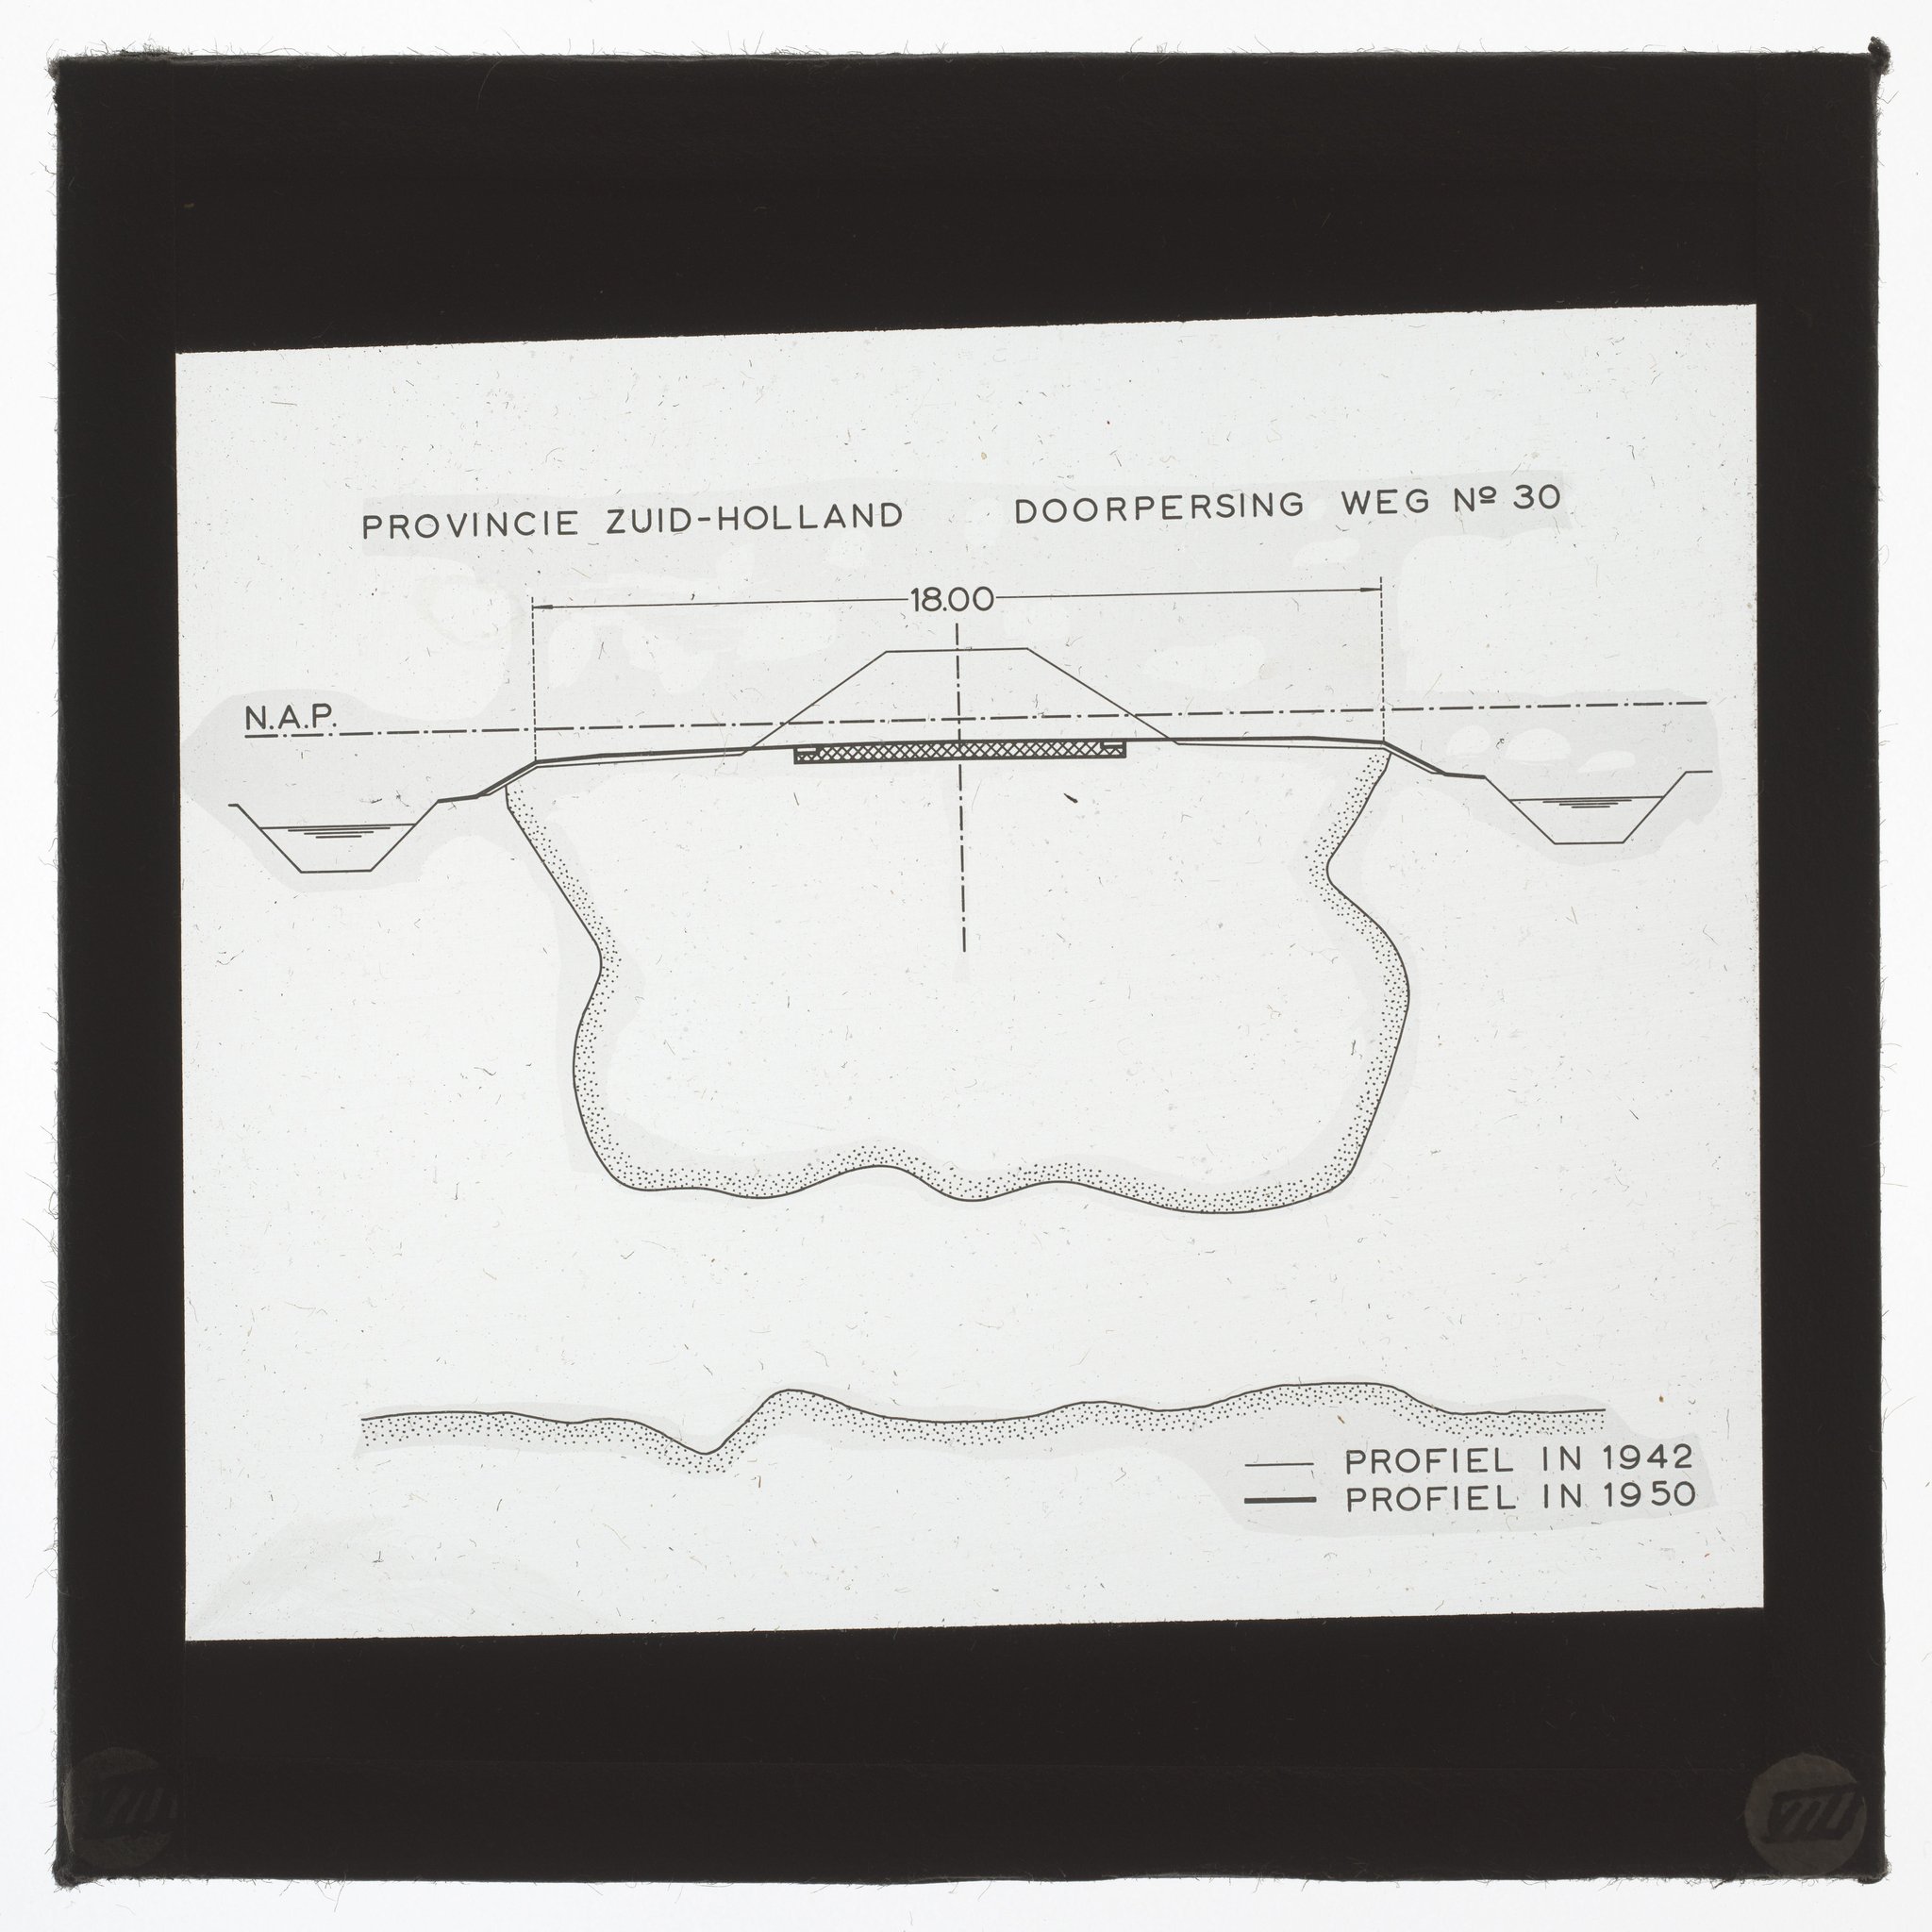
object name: lantern slide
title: Dwarsdoorsnede van een weg in Zuid-Holland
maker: Anonymous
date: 1956-1960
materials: glass, paper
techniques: printing block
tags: statistic diagram, graph; pictorial chart, etc., public road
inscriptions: number: ‘VIII’